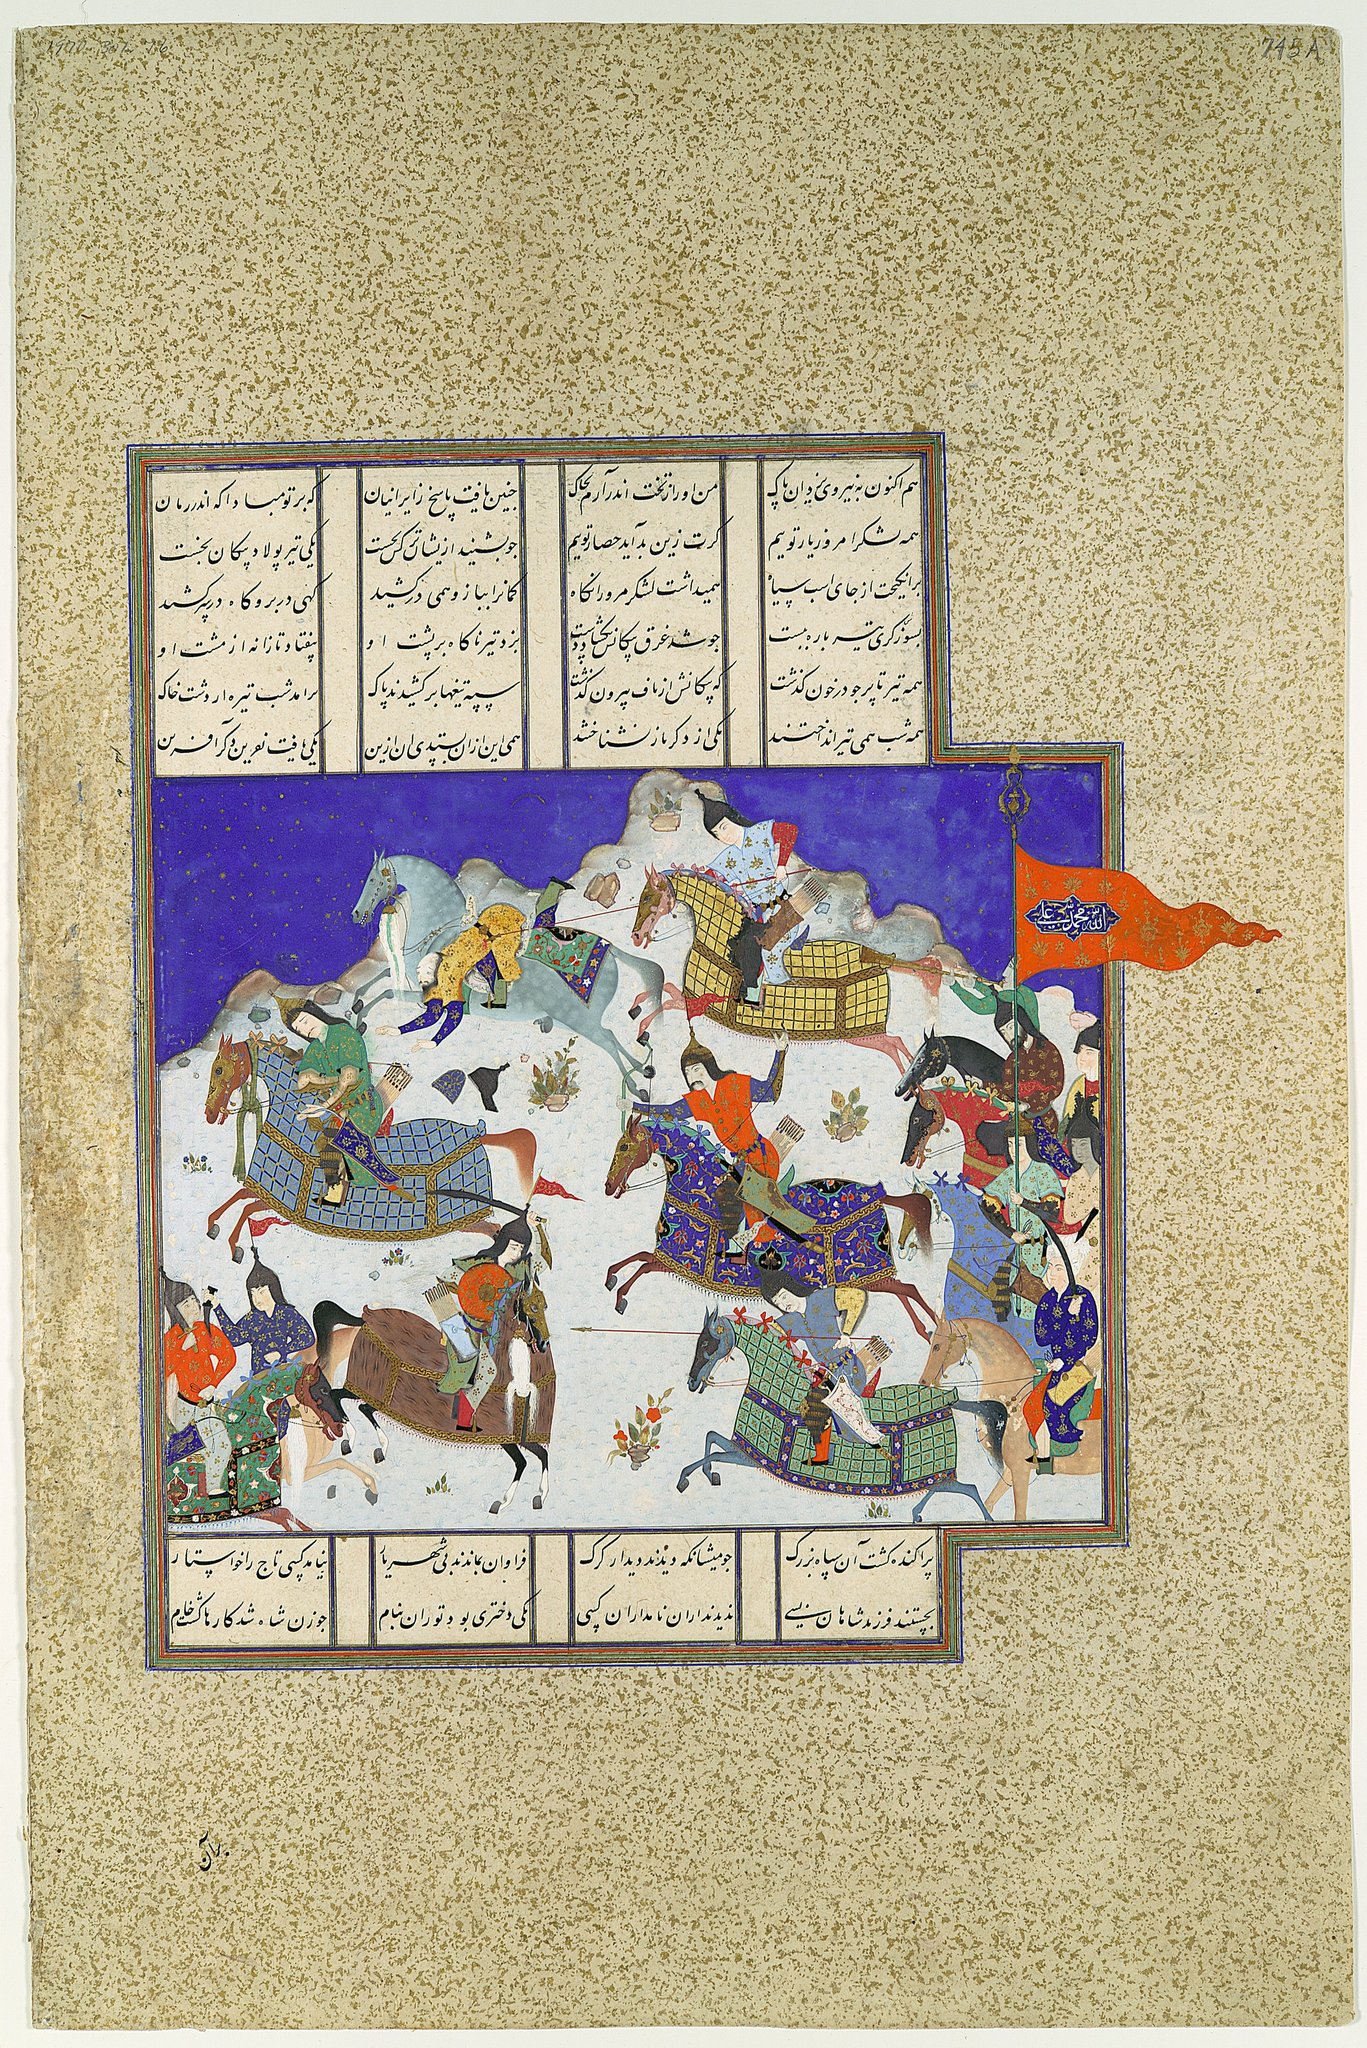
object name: folio from an illustrated manuscript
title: "The Coup against Usurper Shah", Folio 745v from the Shahnama (Book of Kings) of Shah Tahmasp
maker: abu'l qasim firdausi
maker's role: author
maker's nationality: iranian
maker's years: 935-1020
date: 1530-1535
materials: gold, ink, paper, silver, watercolor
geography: iran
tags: battles,army,horses,flags